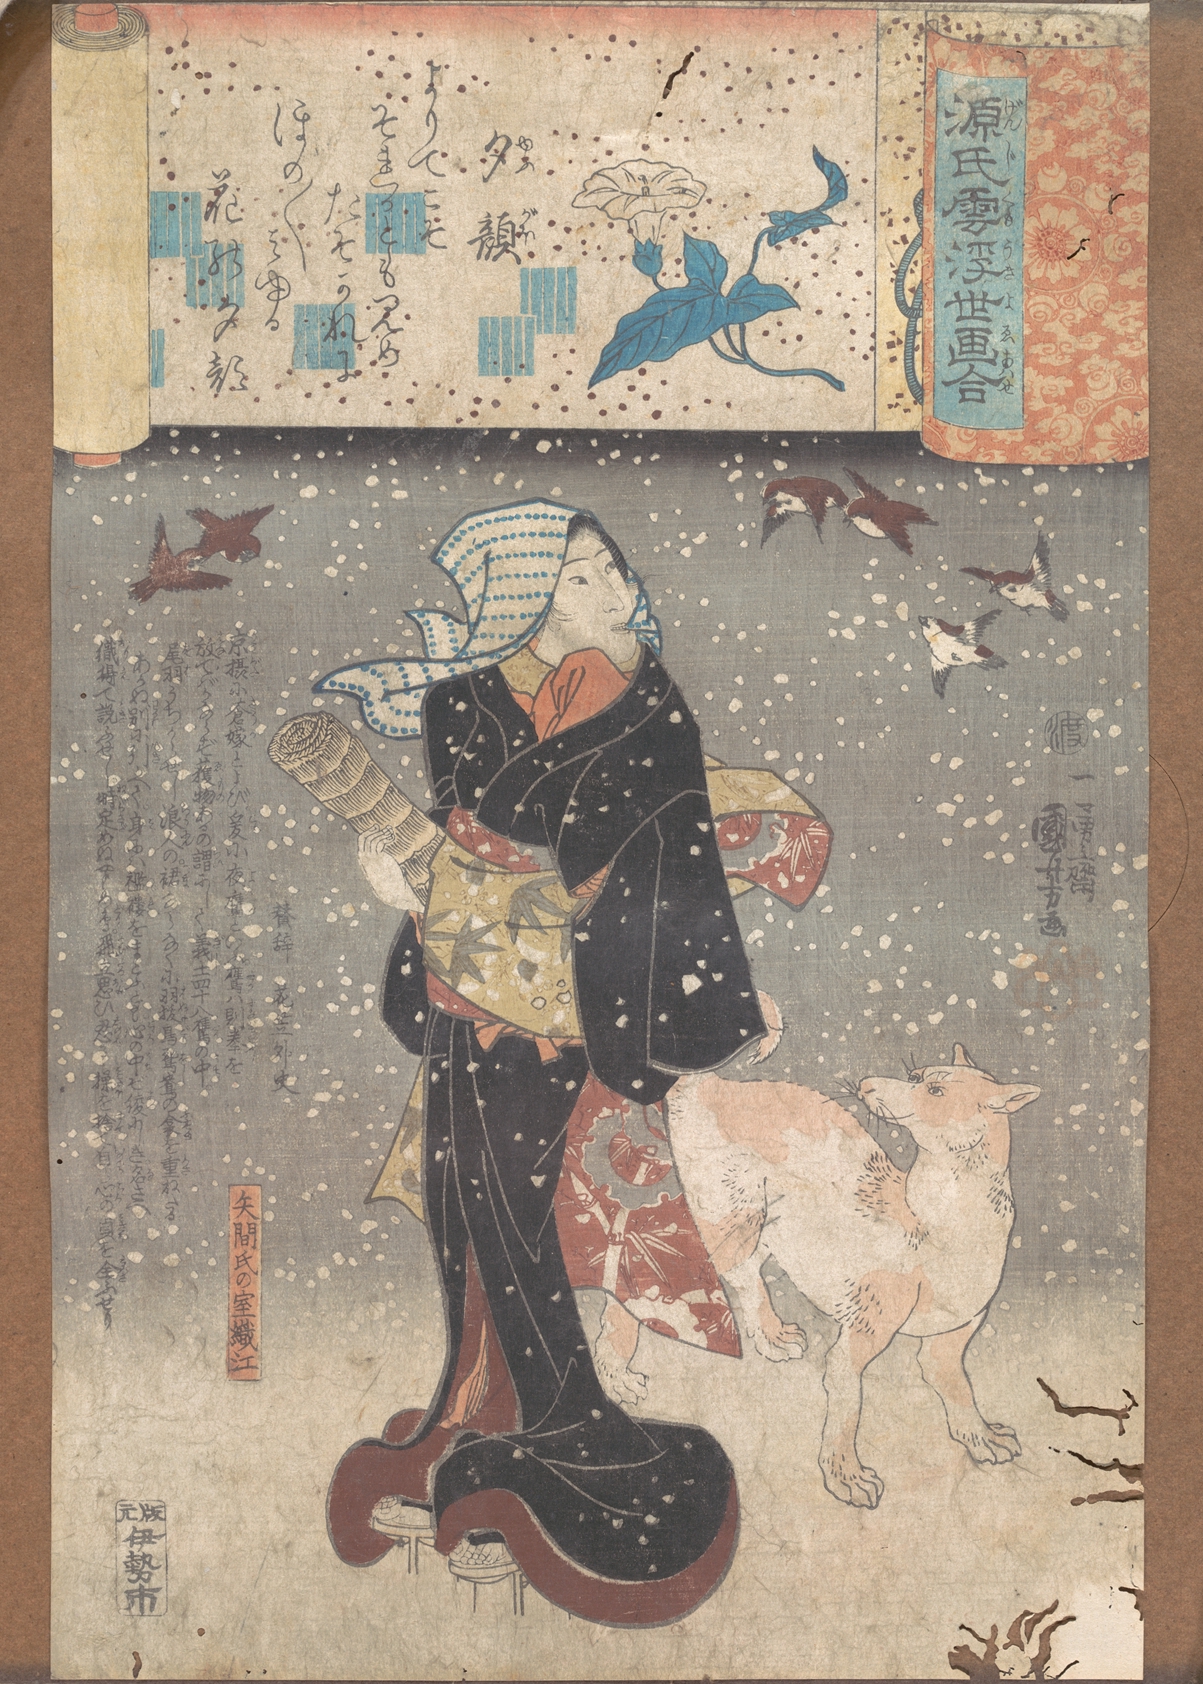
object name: print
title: Evening Faces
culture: japanese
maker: utagawa kuniyoshi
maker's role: artist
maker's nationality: japanese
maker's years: 1797-1861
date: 1845-1846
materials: ink, paper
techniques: woodblock print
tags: birds,women,leaves,evening